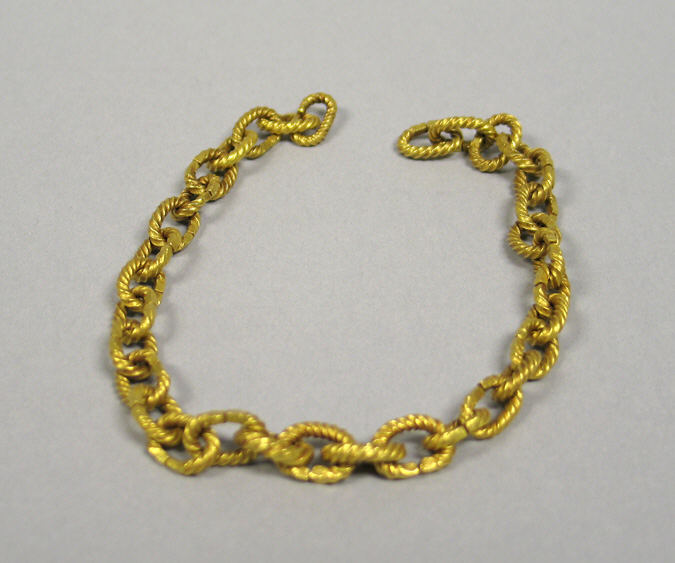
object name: chain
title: Link Chain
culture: indonesian, javanese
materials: gold